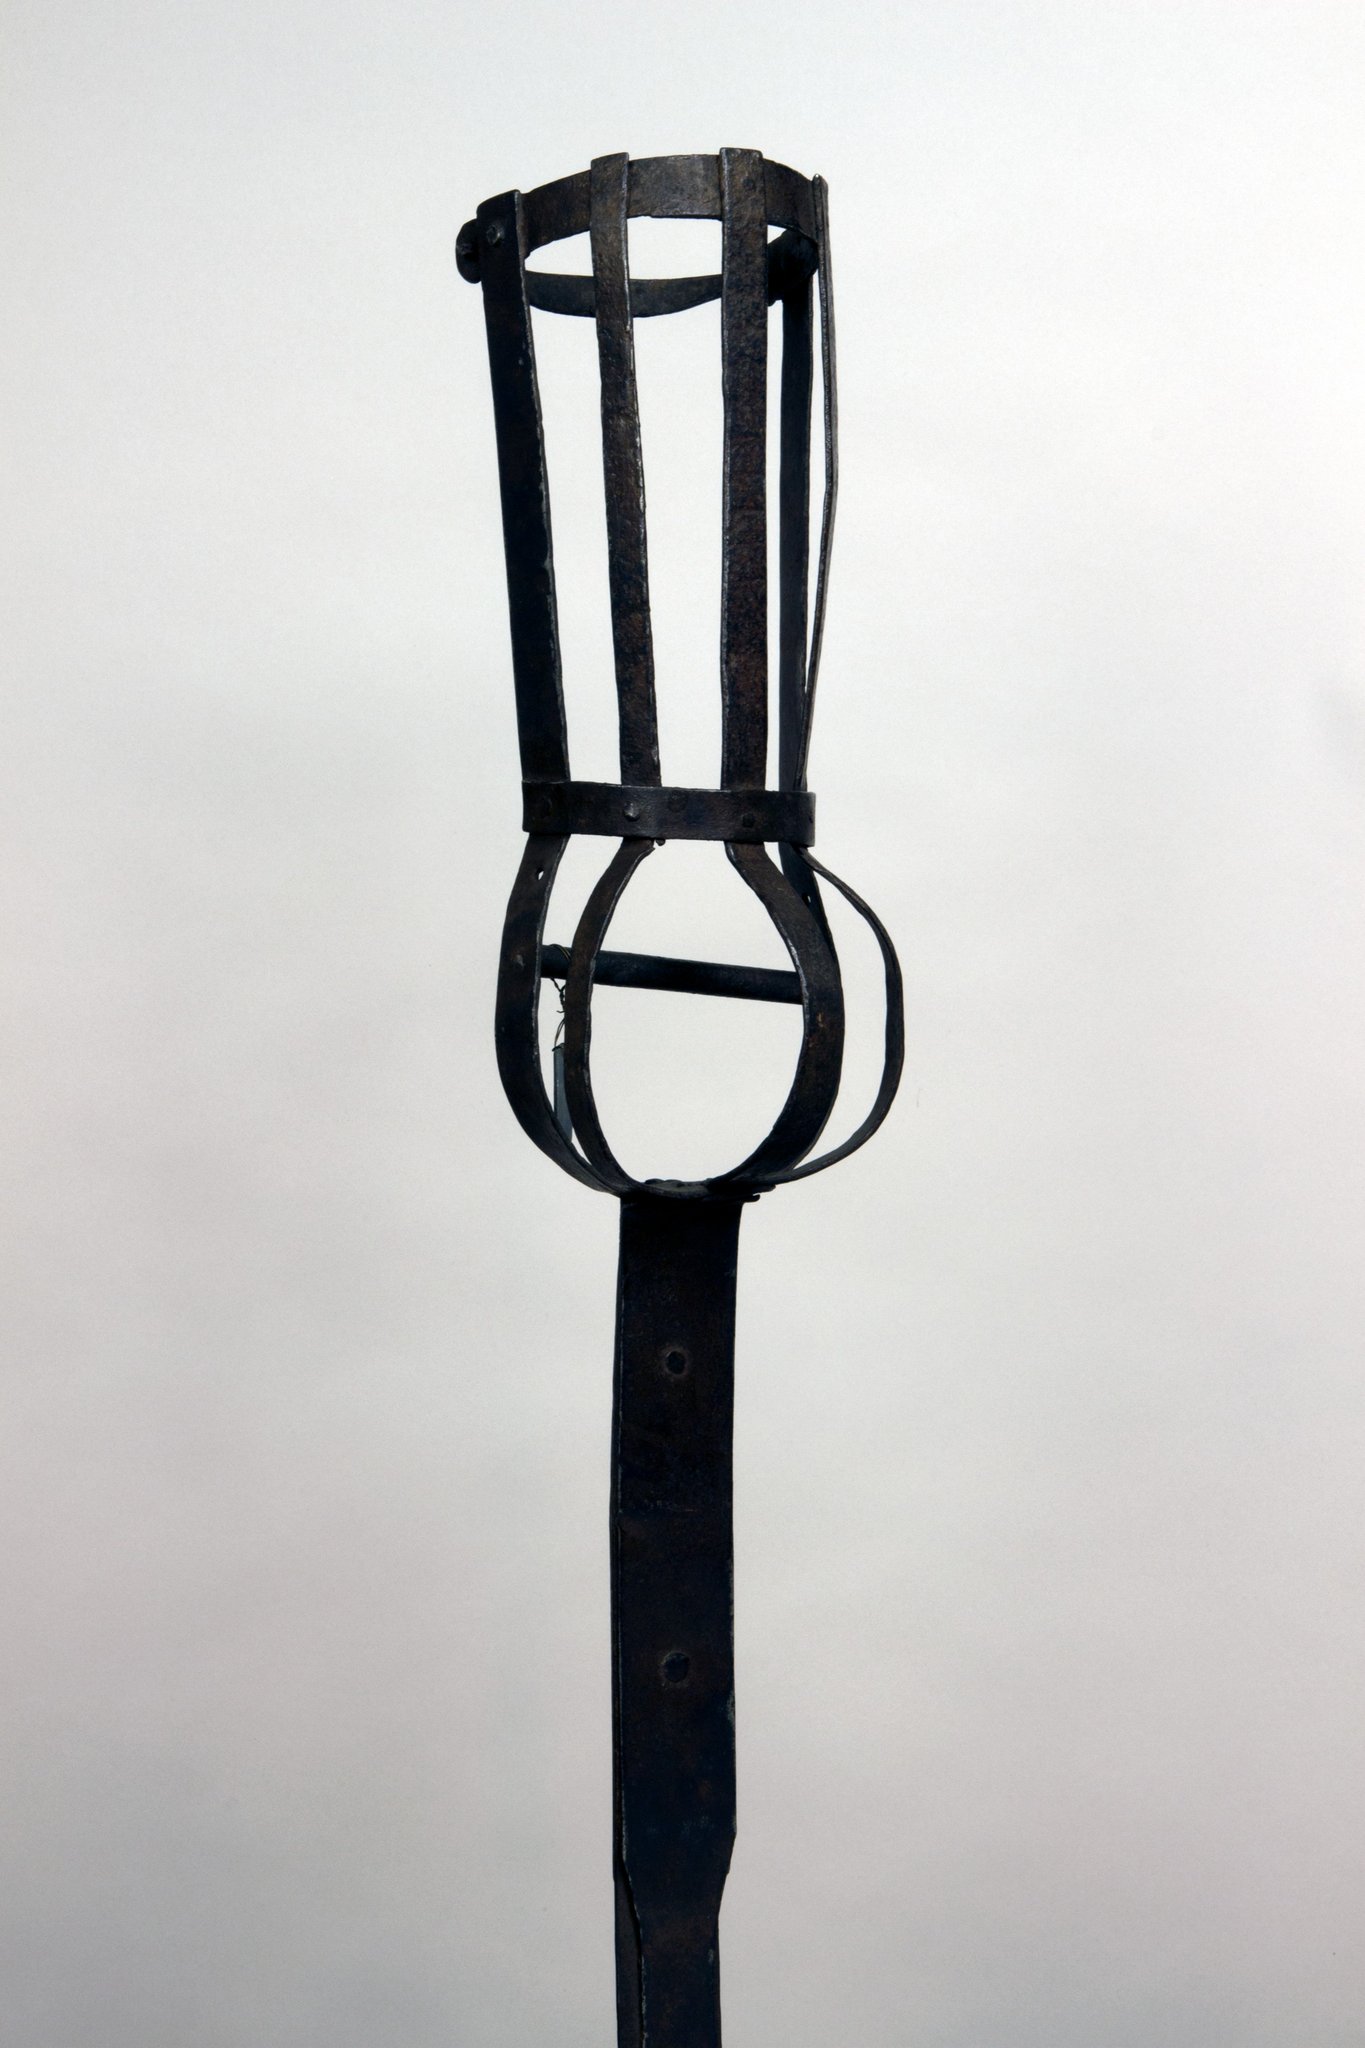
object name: gauntlet sword pata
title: Gauntlet Sword (Pata)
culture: indian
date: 1801-1900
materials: steel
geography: india